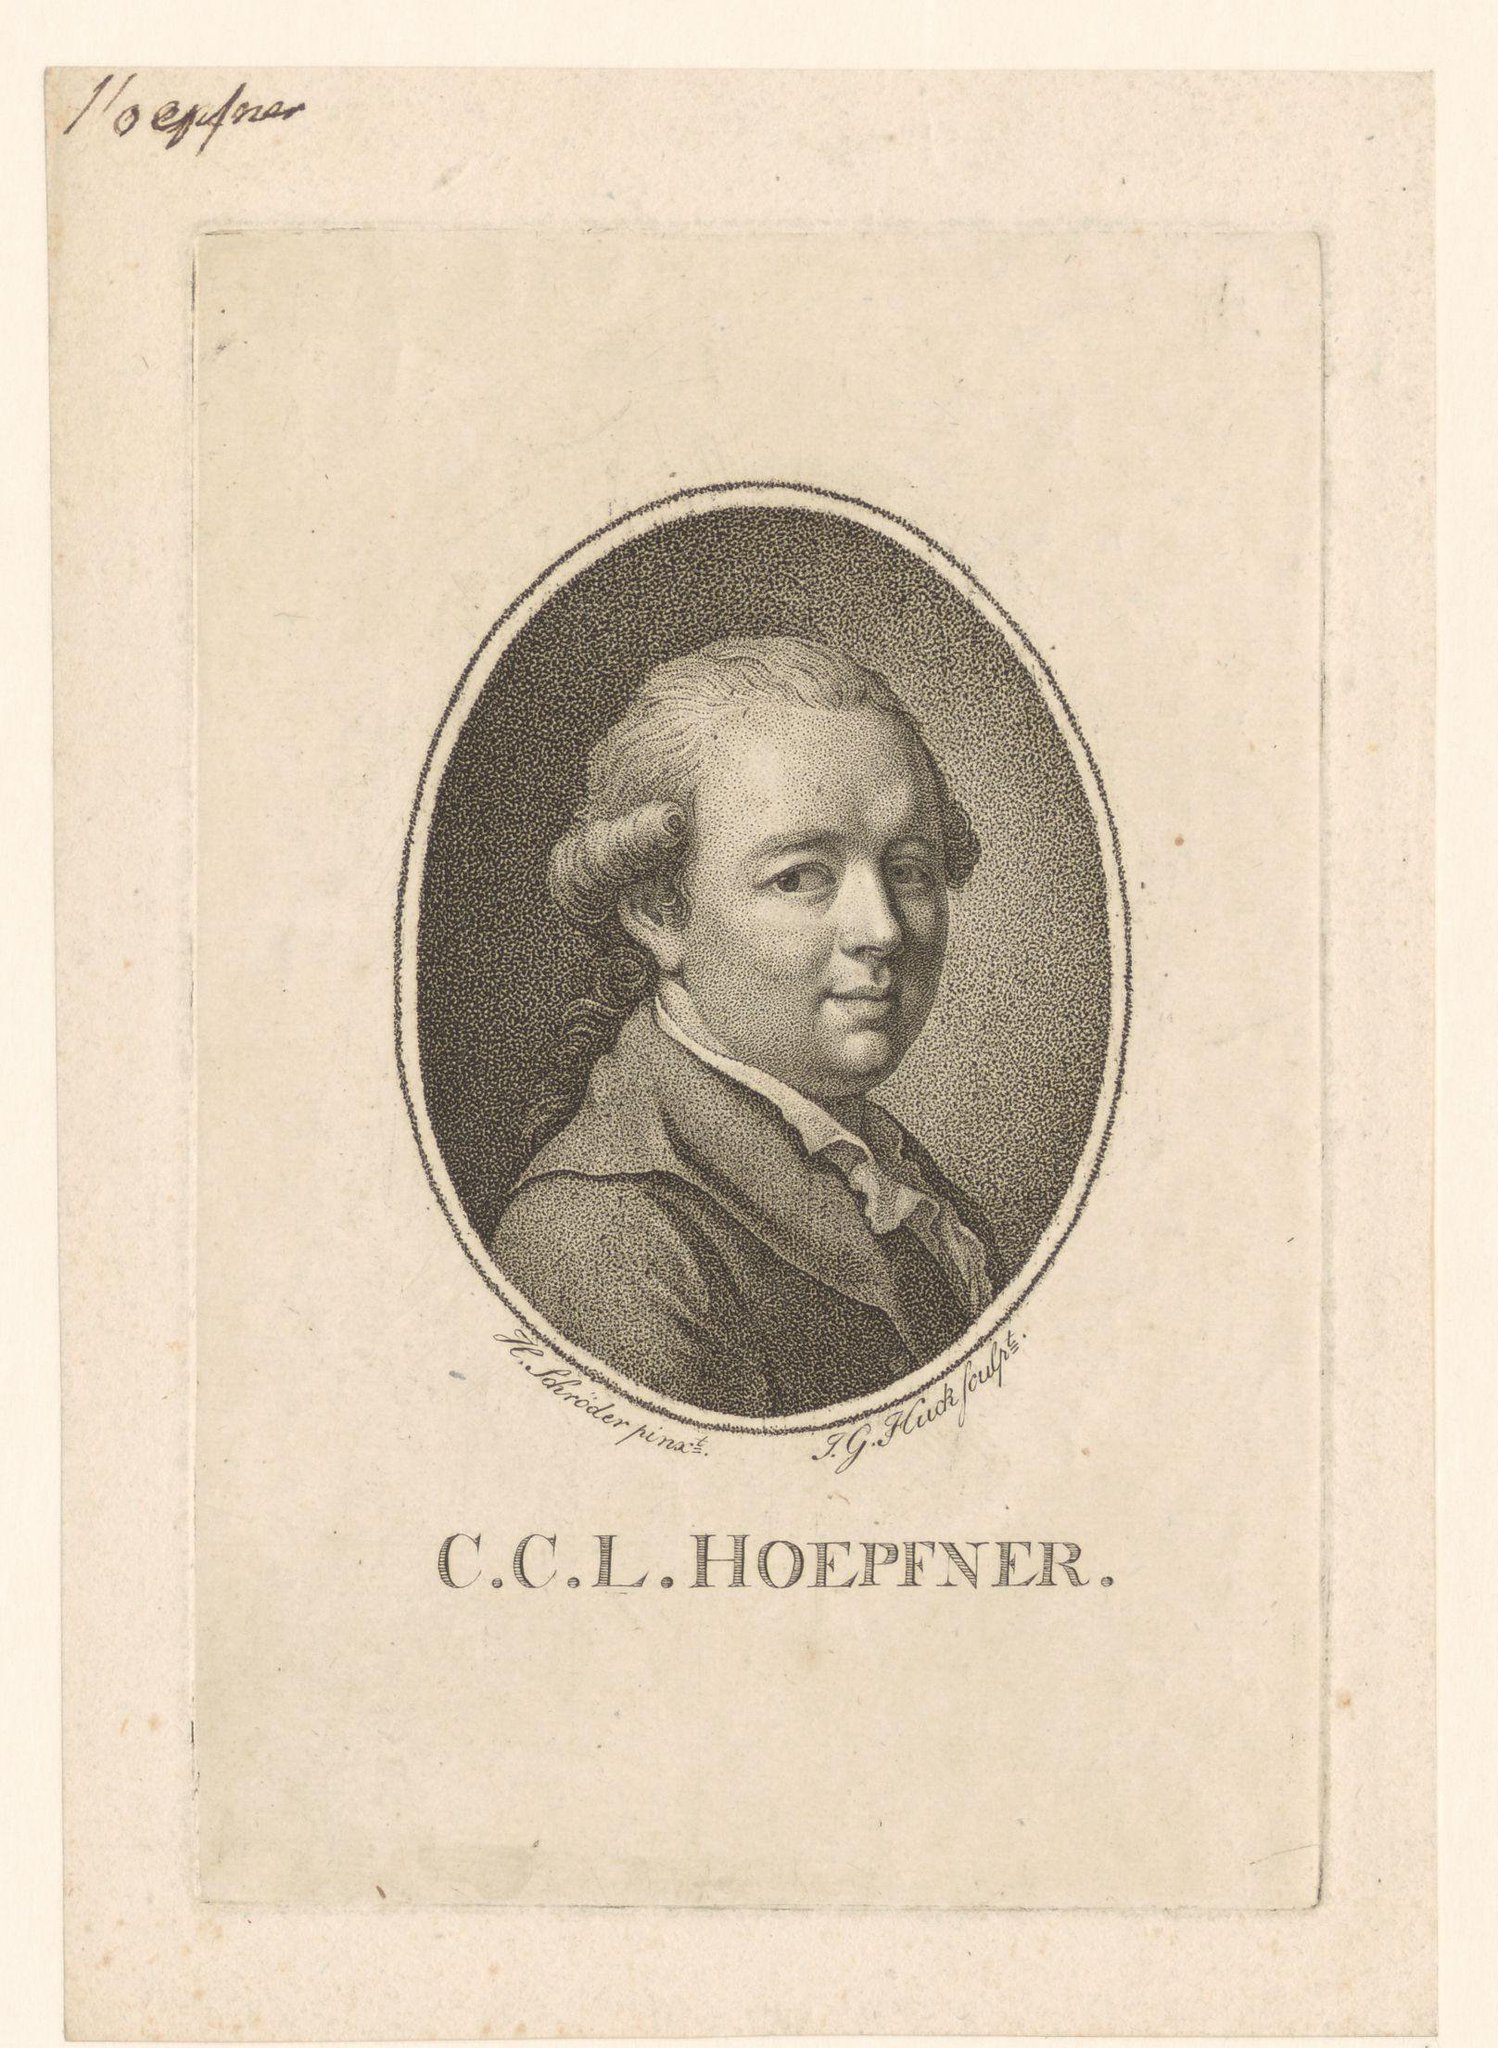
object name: print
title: Portret van Christoph Carl Ludwig Hoepfner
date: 1769-1811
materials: paper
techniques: stippling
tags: historical persons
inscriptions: annotation: ‘Hoepfner’, collector's mark: Lugt 2228